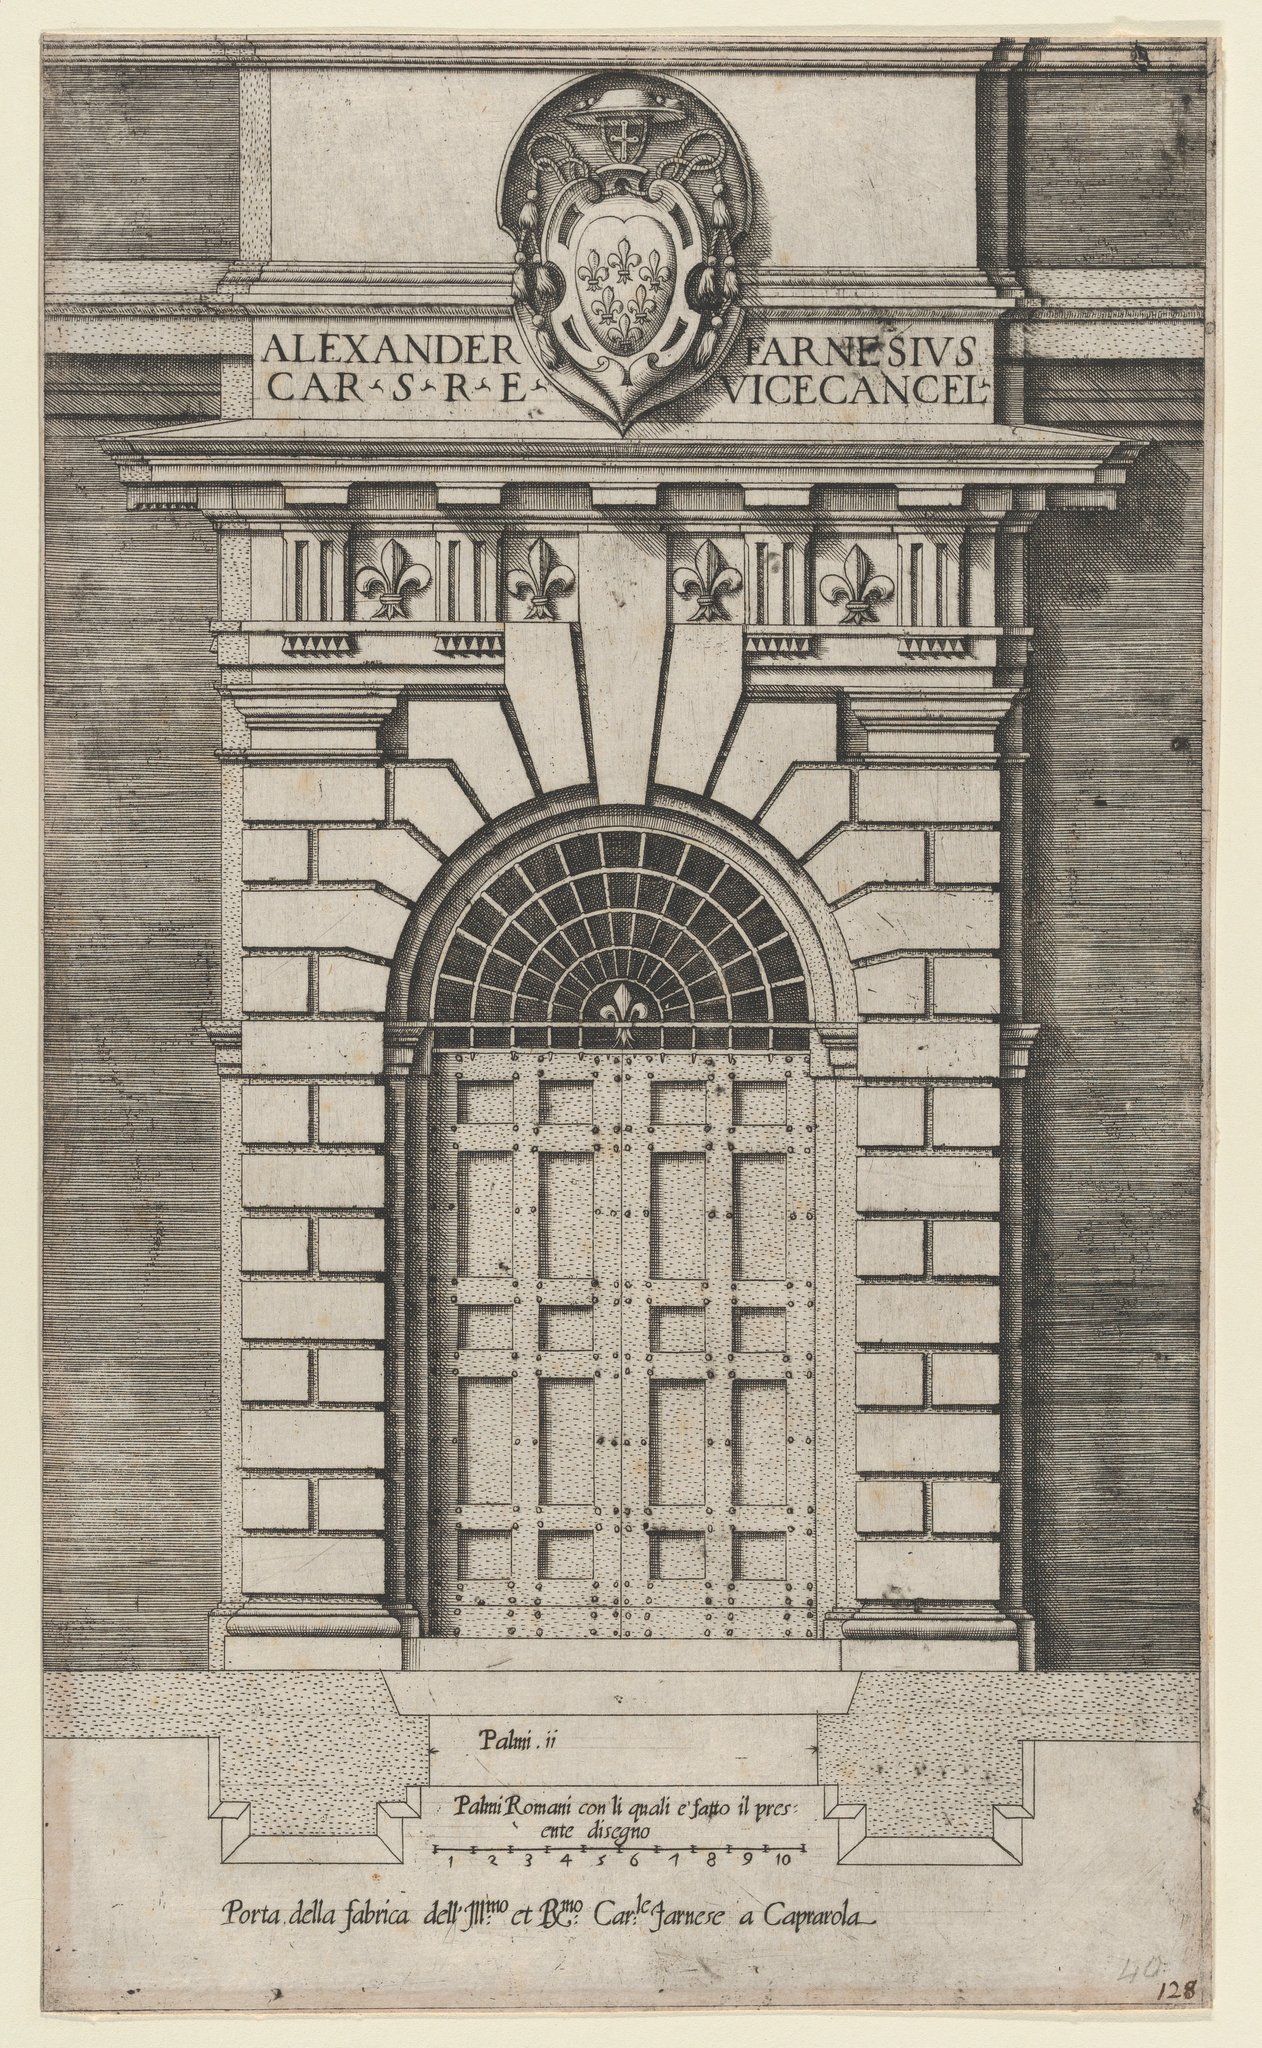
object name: print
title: Porta della fabrica of the Farnese Palace, Caprarola, from "Speculum Romanae Magnificentiae"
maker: Anonymous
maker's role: artist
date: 1501-1600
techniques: engraving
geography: rome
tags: architecture,gates,coat of arms,rome